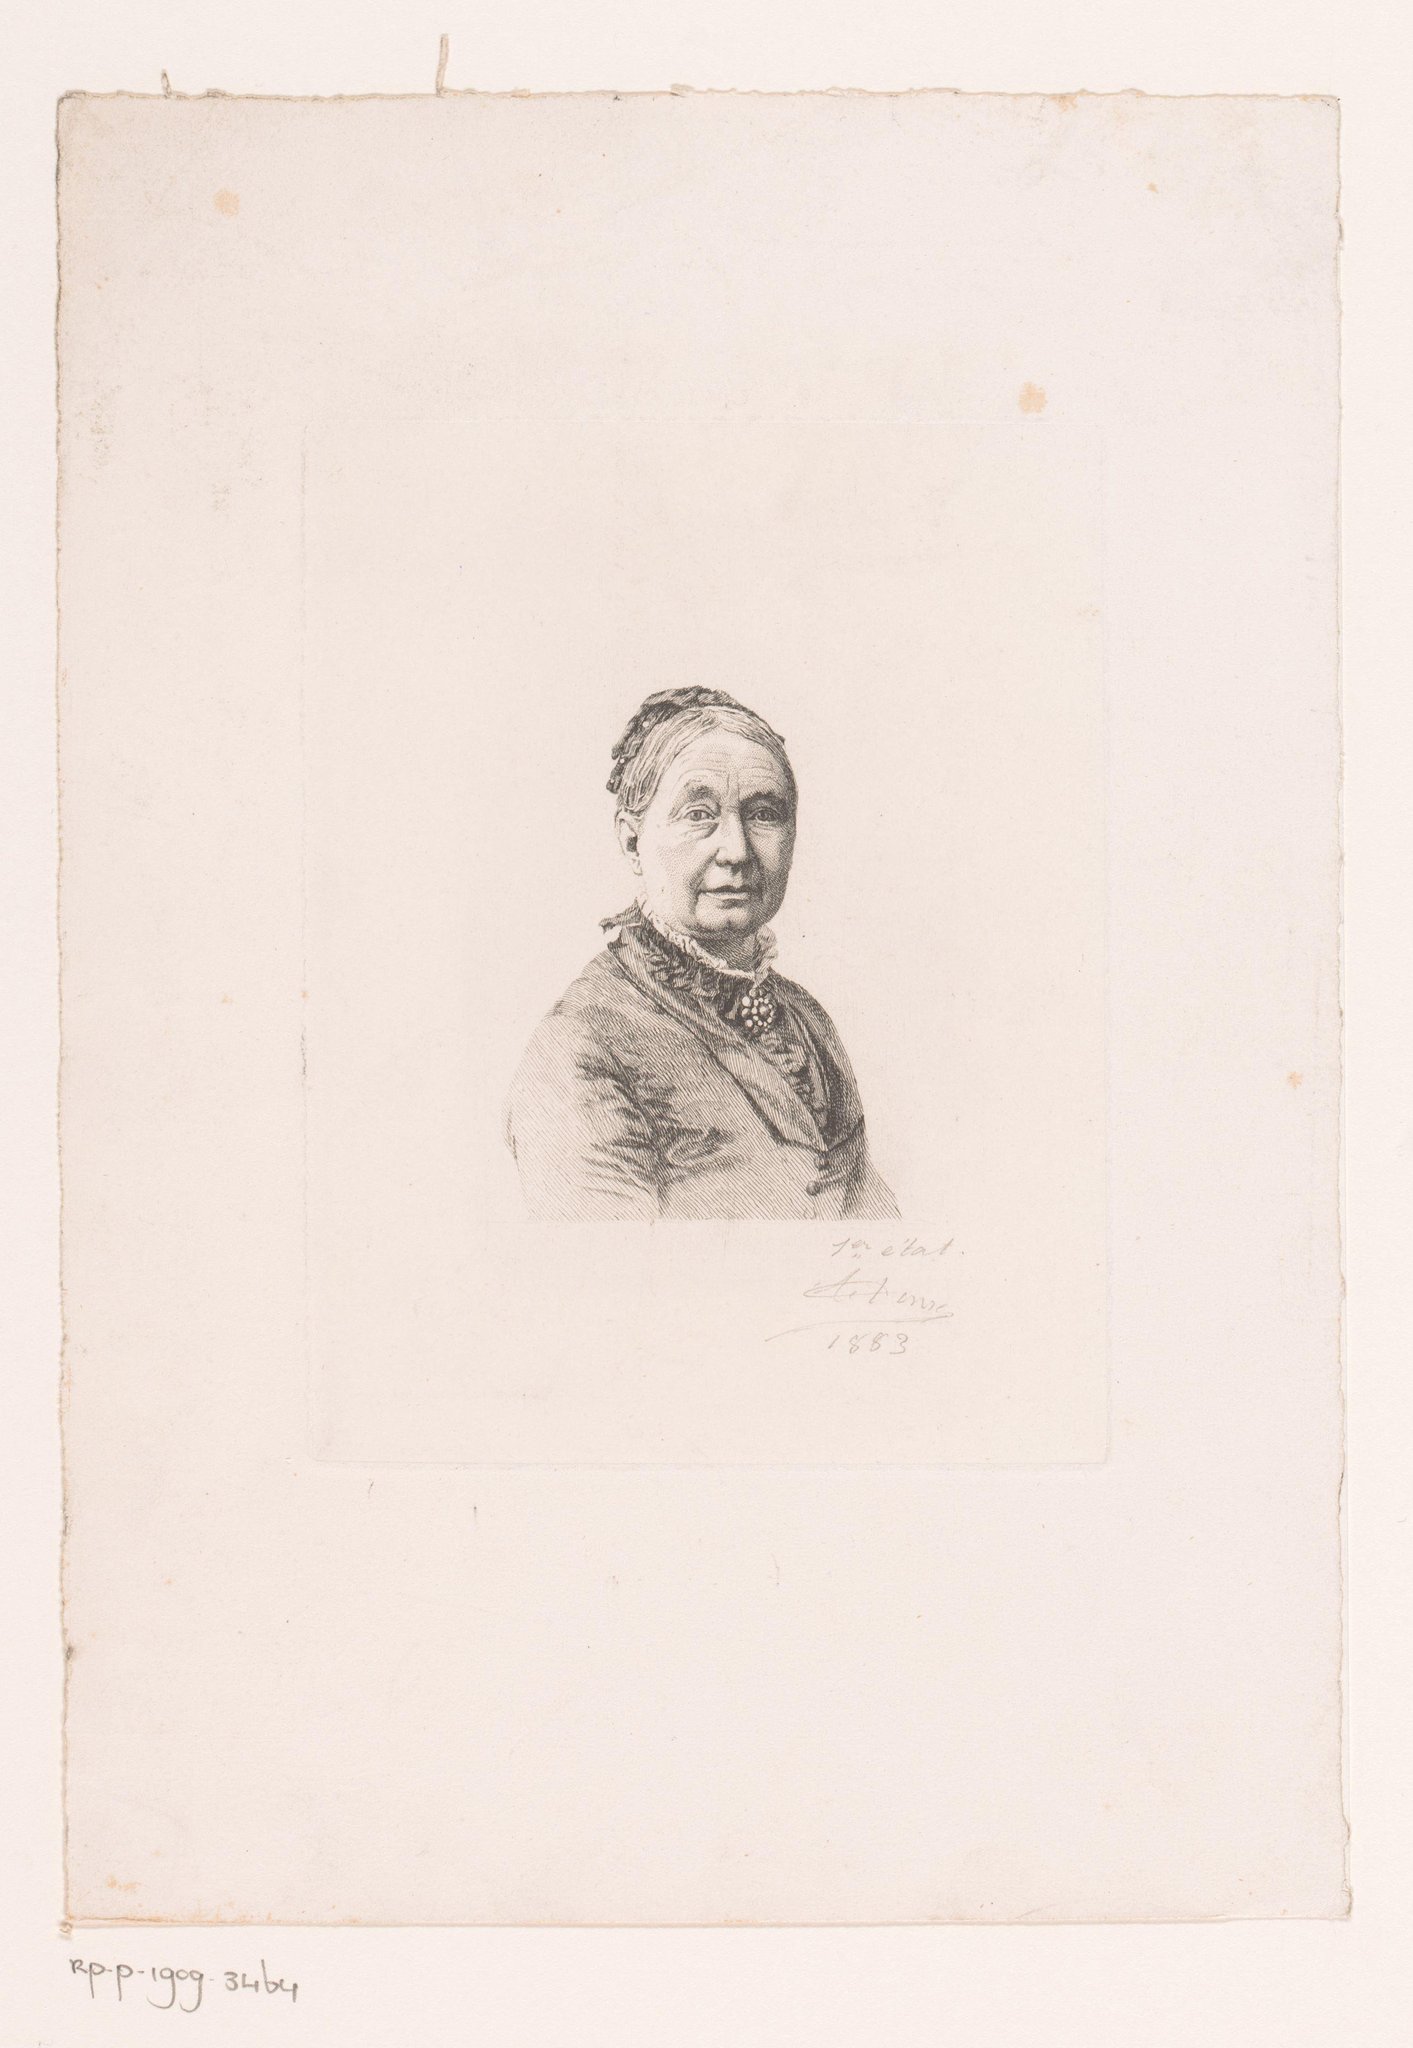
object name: print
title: Portret een onbekende vrouw, mogelijk mevrouw Courtois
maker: auguste danse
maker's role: print maker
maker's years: 1829-1929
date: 1883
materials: paper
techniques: etching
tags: historical person (with name) - bb - woman - historical person (with name) portrayed alone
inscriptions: annotation: ‘1er état’, collector's mark: Lugt 2228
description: De identificatie madame Cousin is gebaseerd op een potloodaantekening op een latere staat van dezelfde prent in de collectie van het Rijksmuseum Amsterdam.